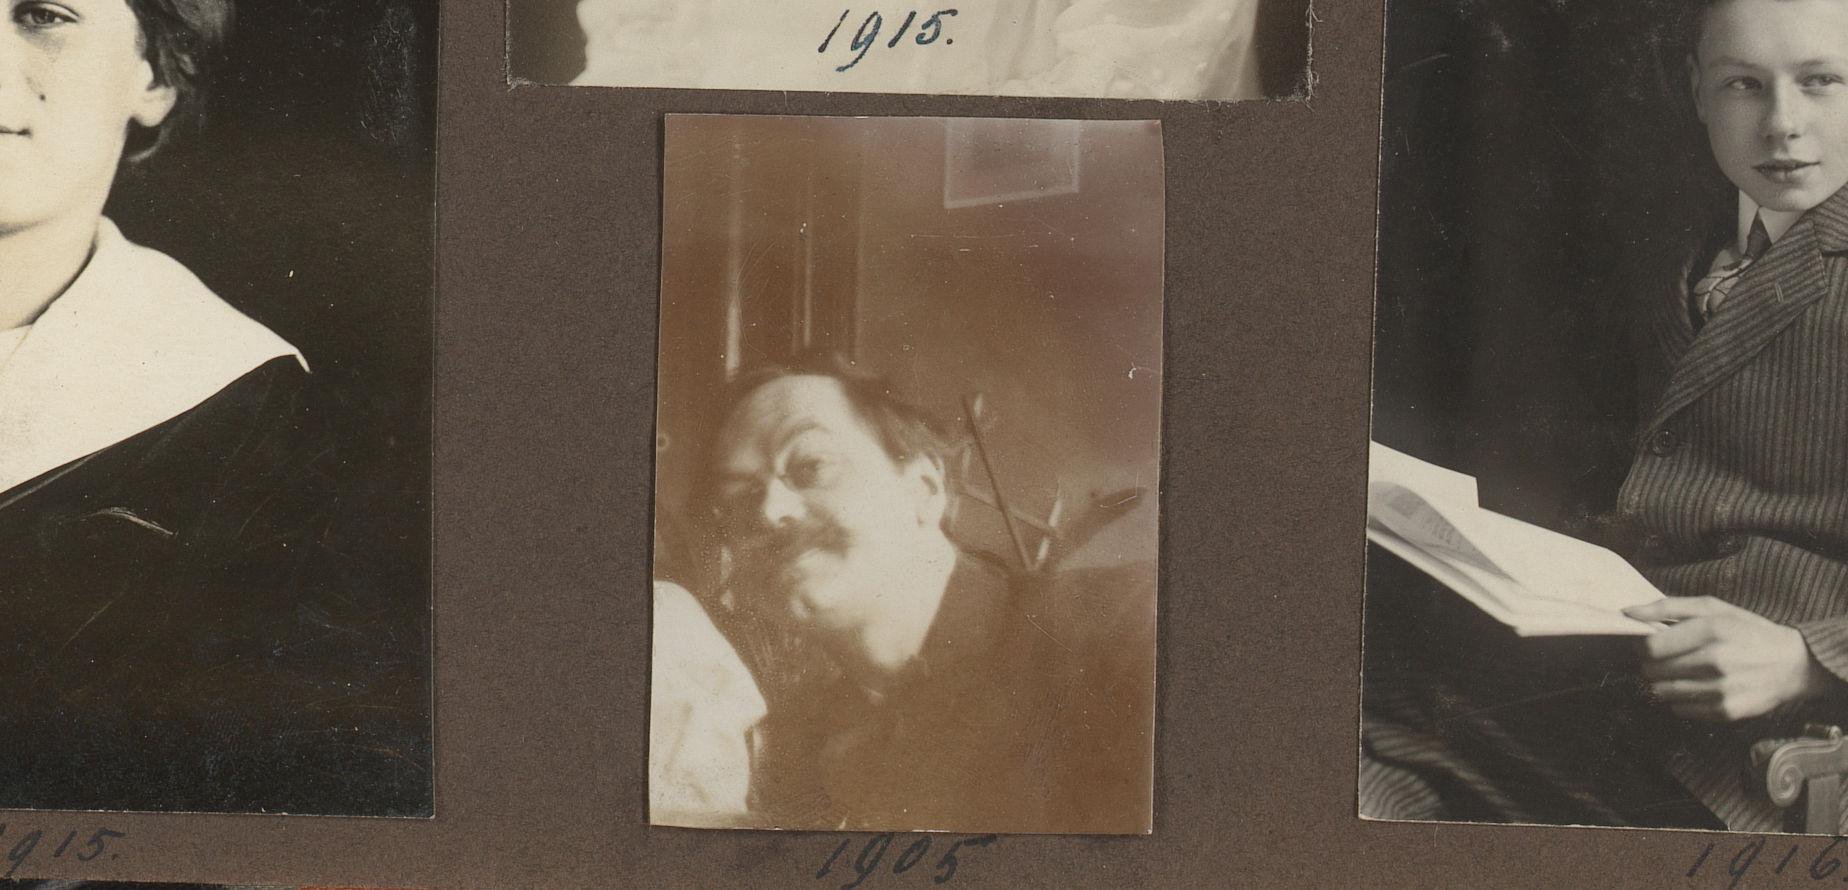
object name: photograph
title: Alphons Diepenbrock in een huiskamer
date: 1905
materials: paper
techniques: gelatin silver print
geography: netherlands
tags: amsterdam, alphons diepenbrock, historical persons, living-room, parlour, sitting-room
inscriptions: date: ‘1905’